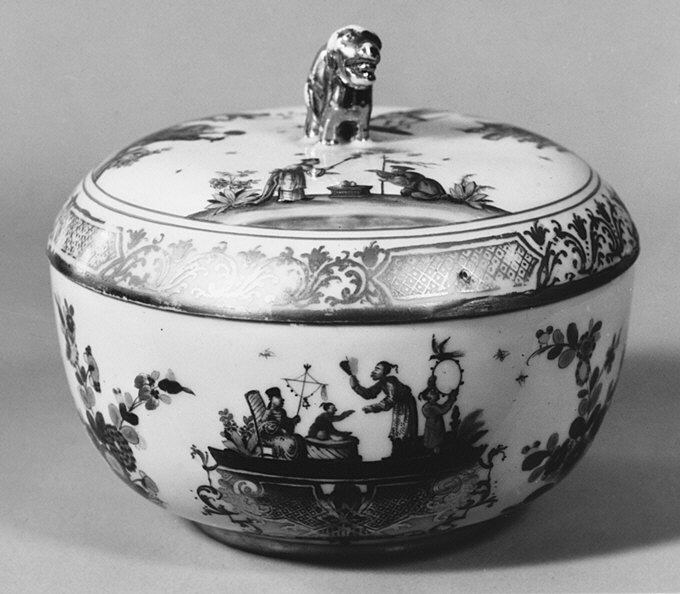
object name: bowl with cover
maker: meissen manufactory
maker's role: manufactory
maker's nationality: german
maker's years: 1710-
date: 1730-1735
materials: porcelain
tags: human figures,chinoiserie